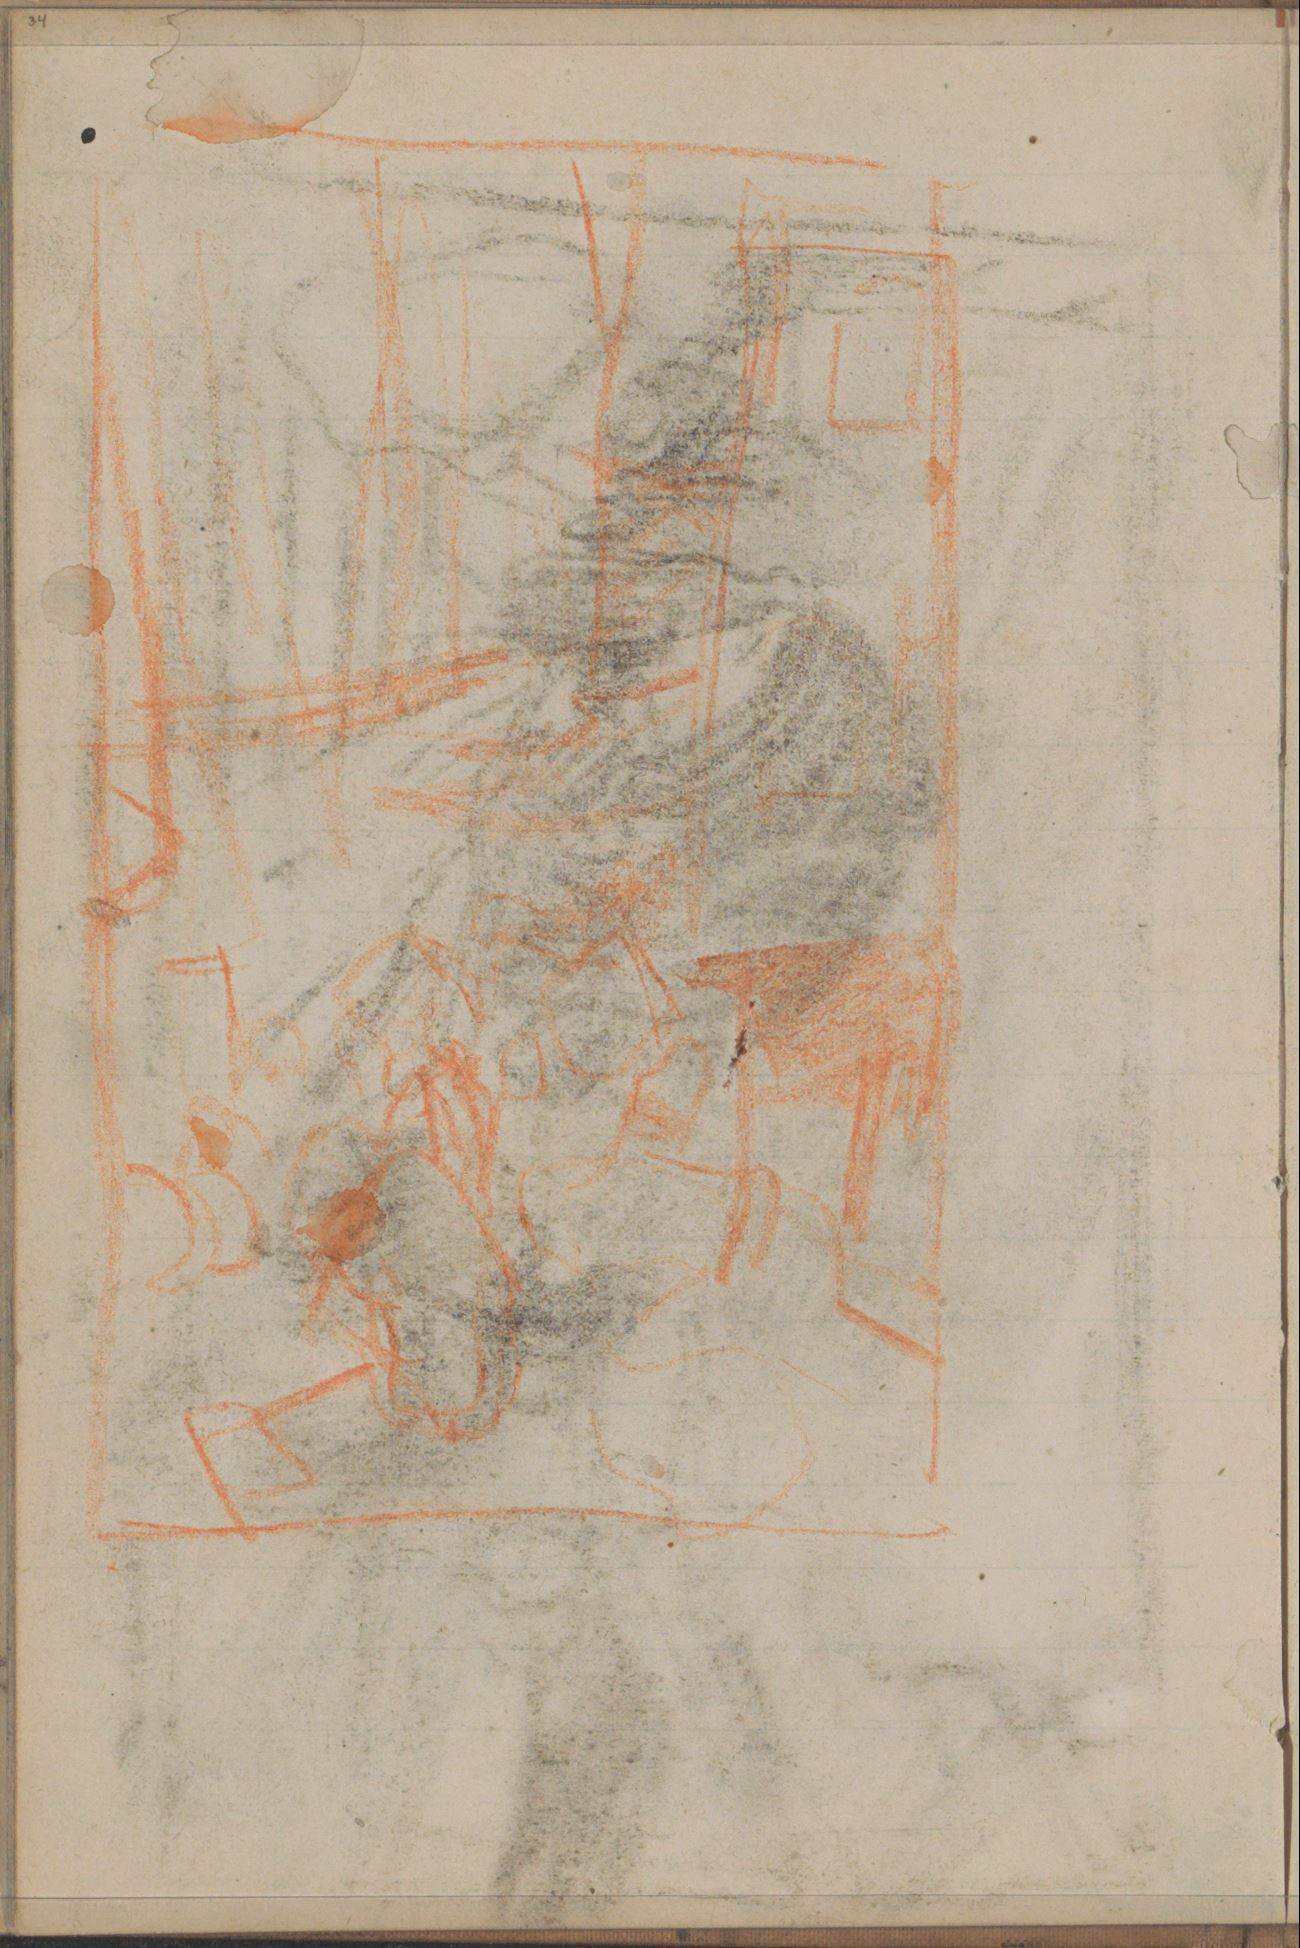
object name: sketchbook leaf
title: Studieblad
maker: marius bauer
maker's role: draughtsman, print maker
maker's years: 1867-1932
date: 1888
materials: chalk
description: Pagina 34 uit een schetsboek met 49 bladen.